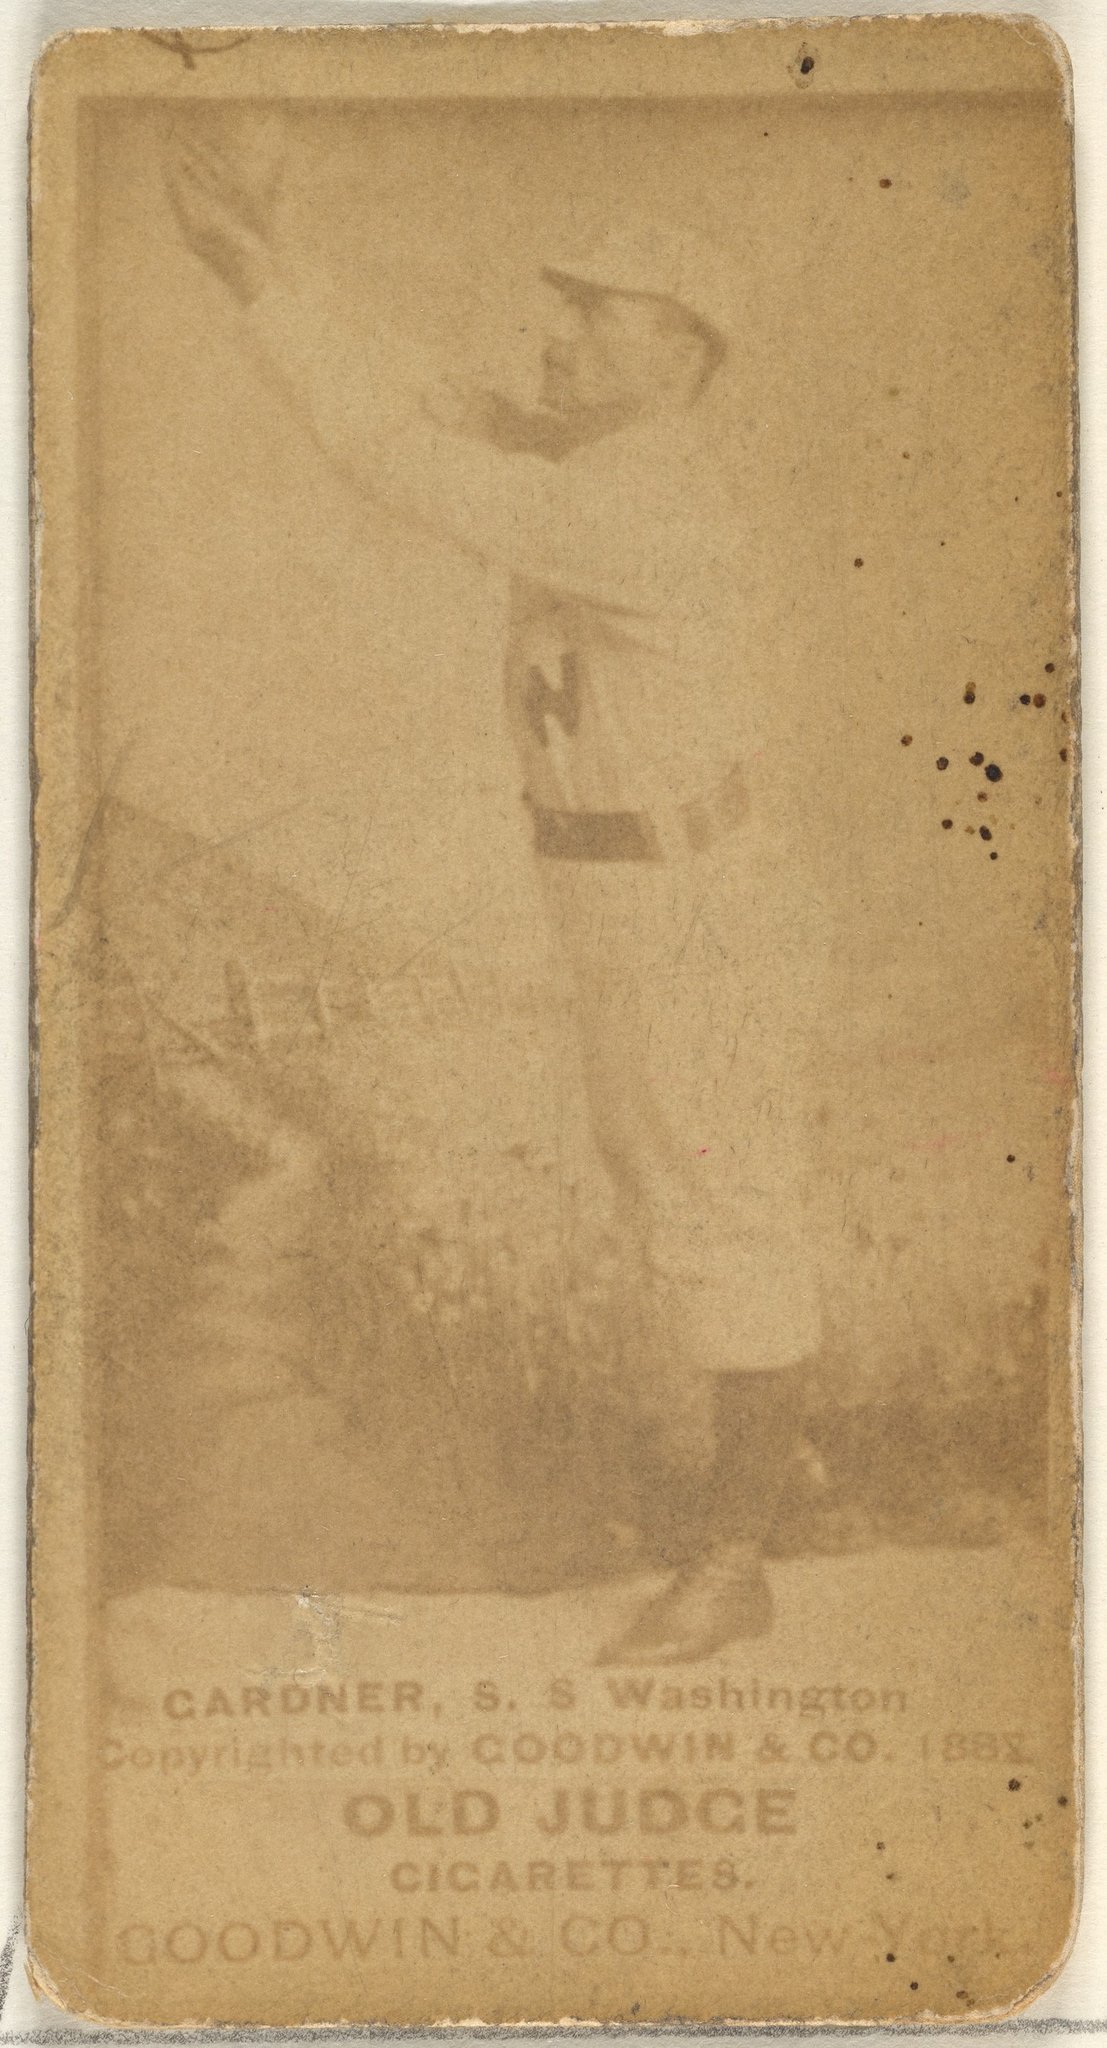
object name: baseball card, photograph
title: Franklin Washington "Gid" Gardner, Shortstop, Washington Nationals, from the Old Judge series (N172) for Old Judge Cigarettes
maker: goodwin & company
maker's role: publisher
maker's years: 1850-1950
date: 1888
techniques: albumen silver print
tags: men,portraits,baseball,athletes